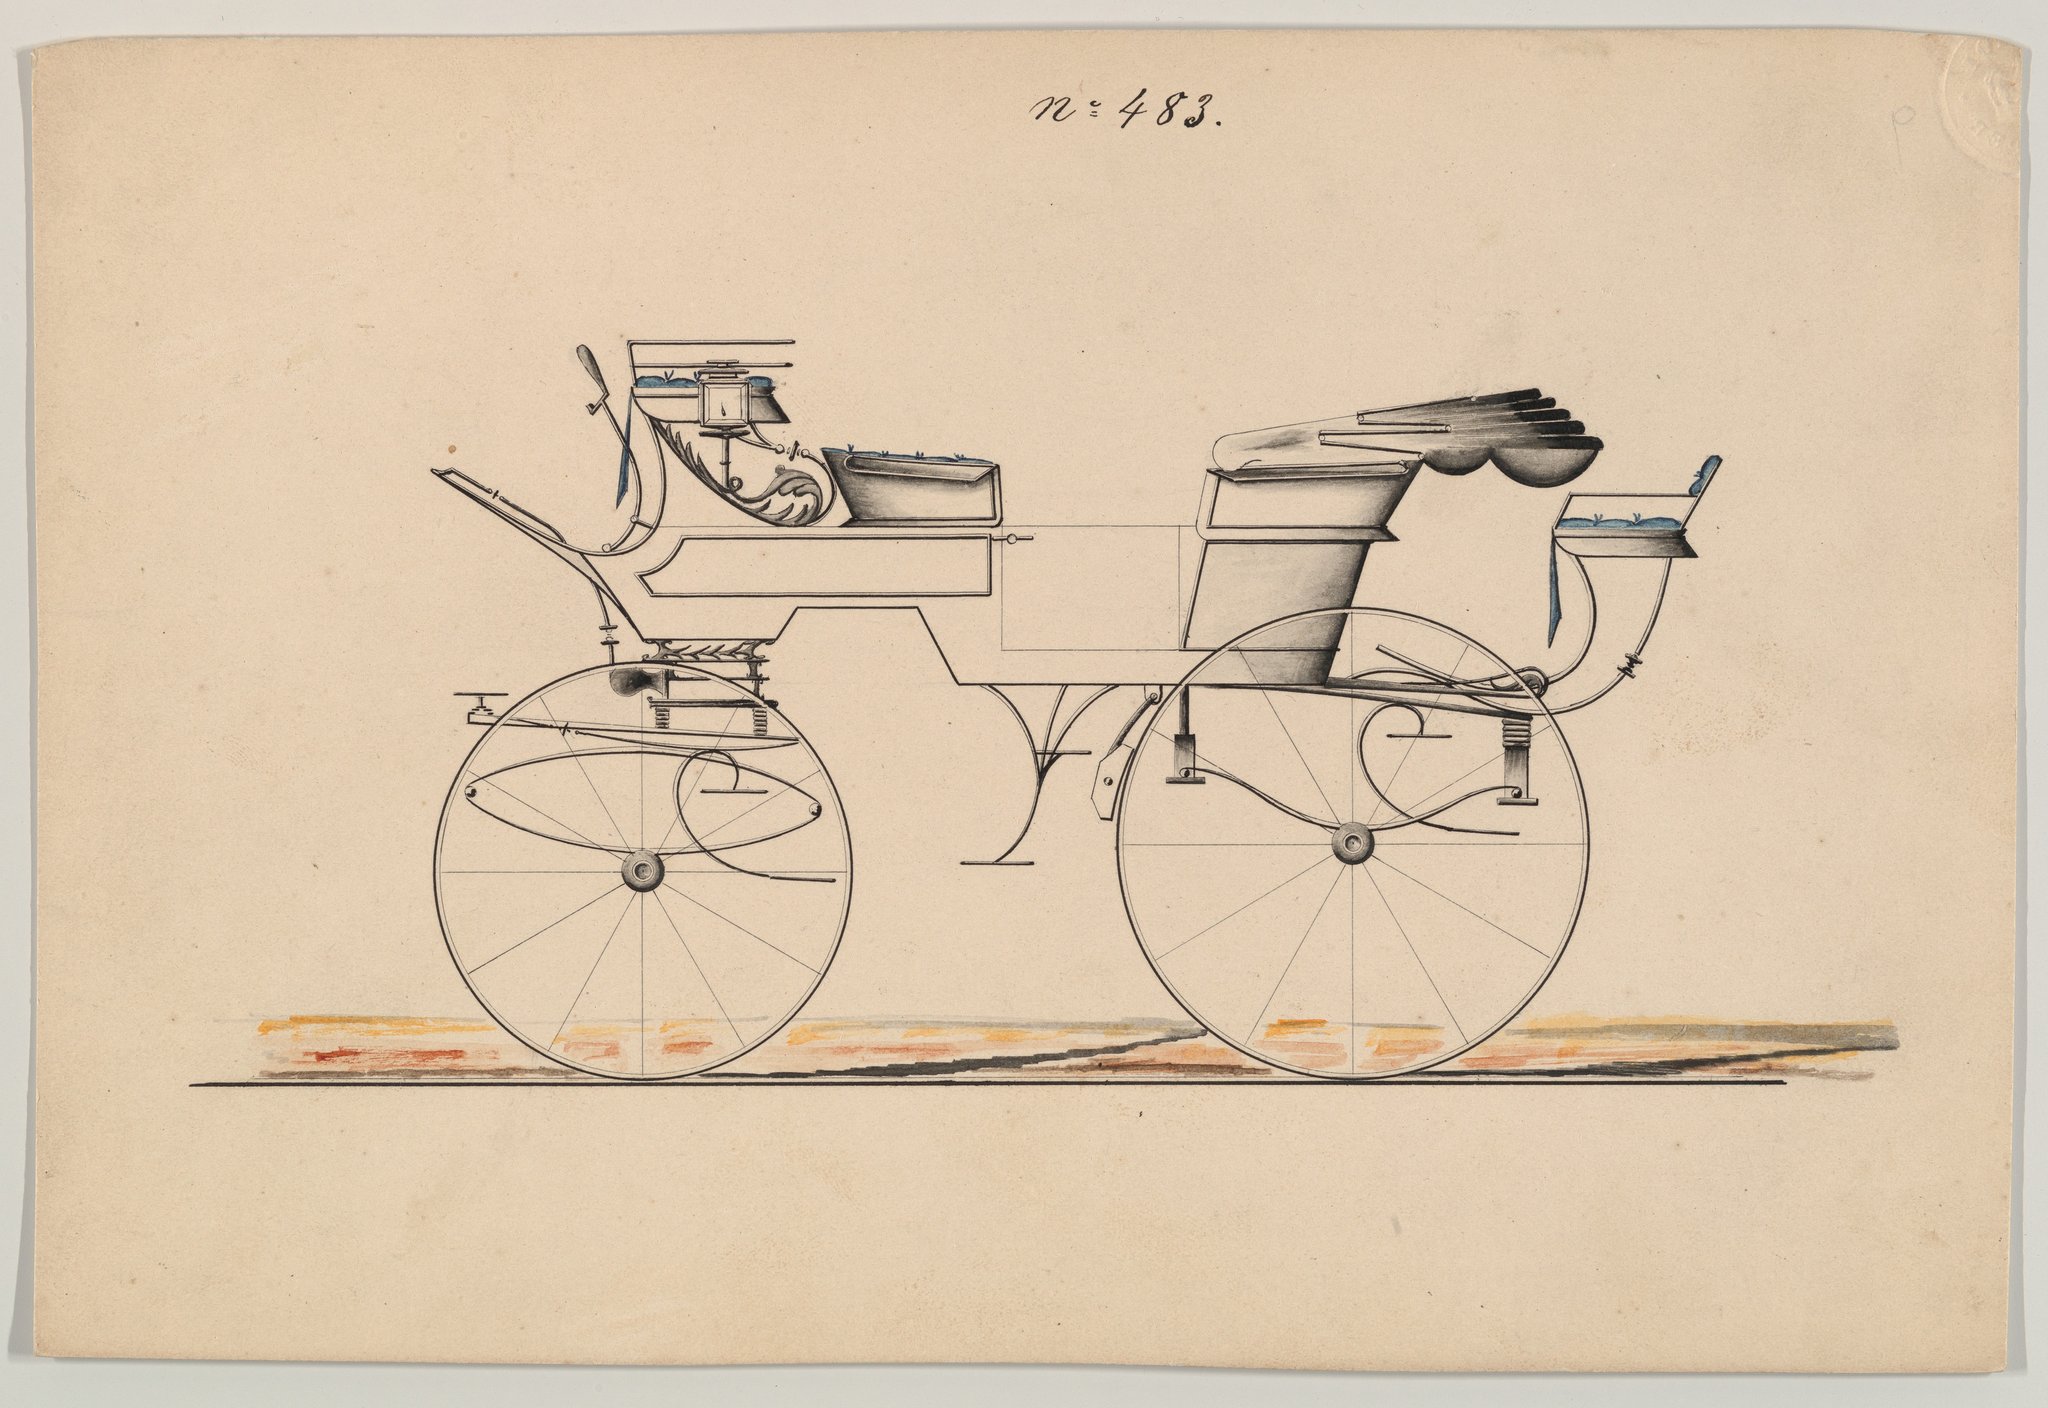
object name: drawing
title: Drag #483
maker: brewster & co.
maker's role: manufacturer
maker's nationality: american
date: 1850-1870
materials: ink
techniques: pen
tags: carriages